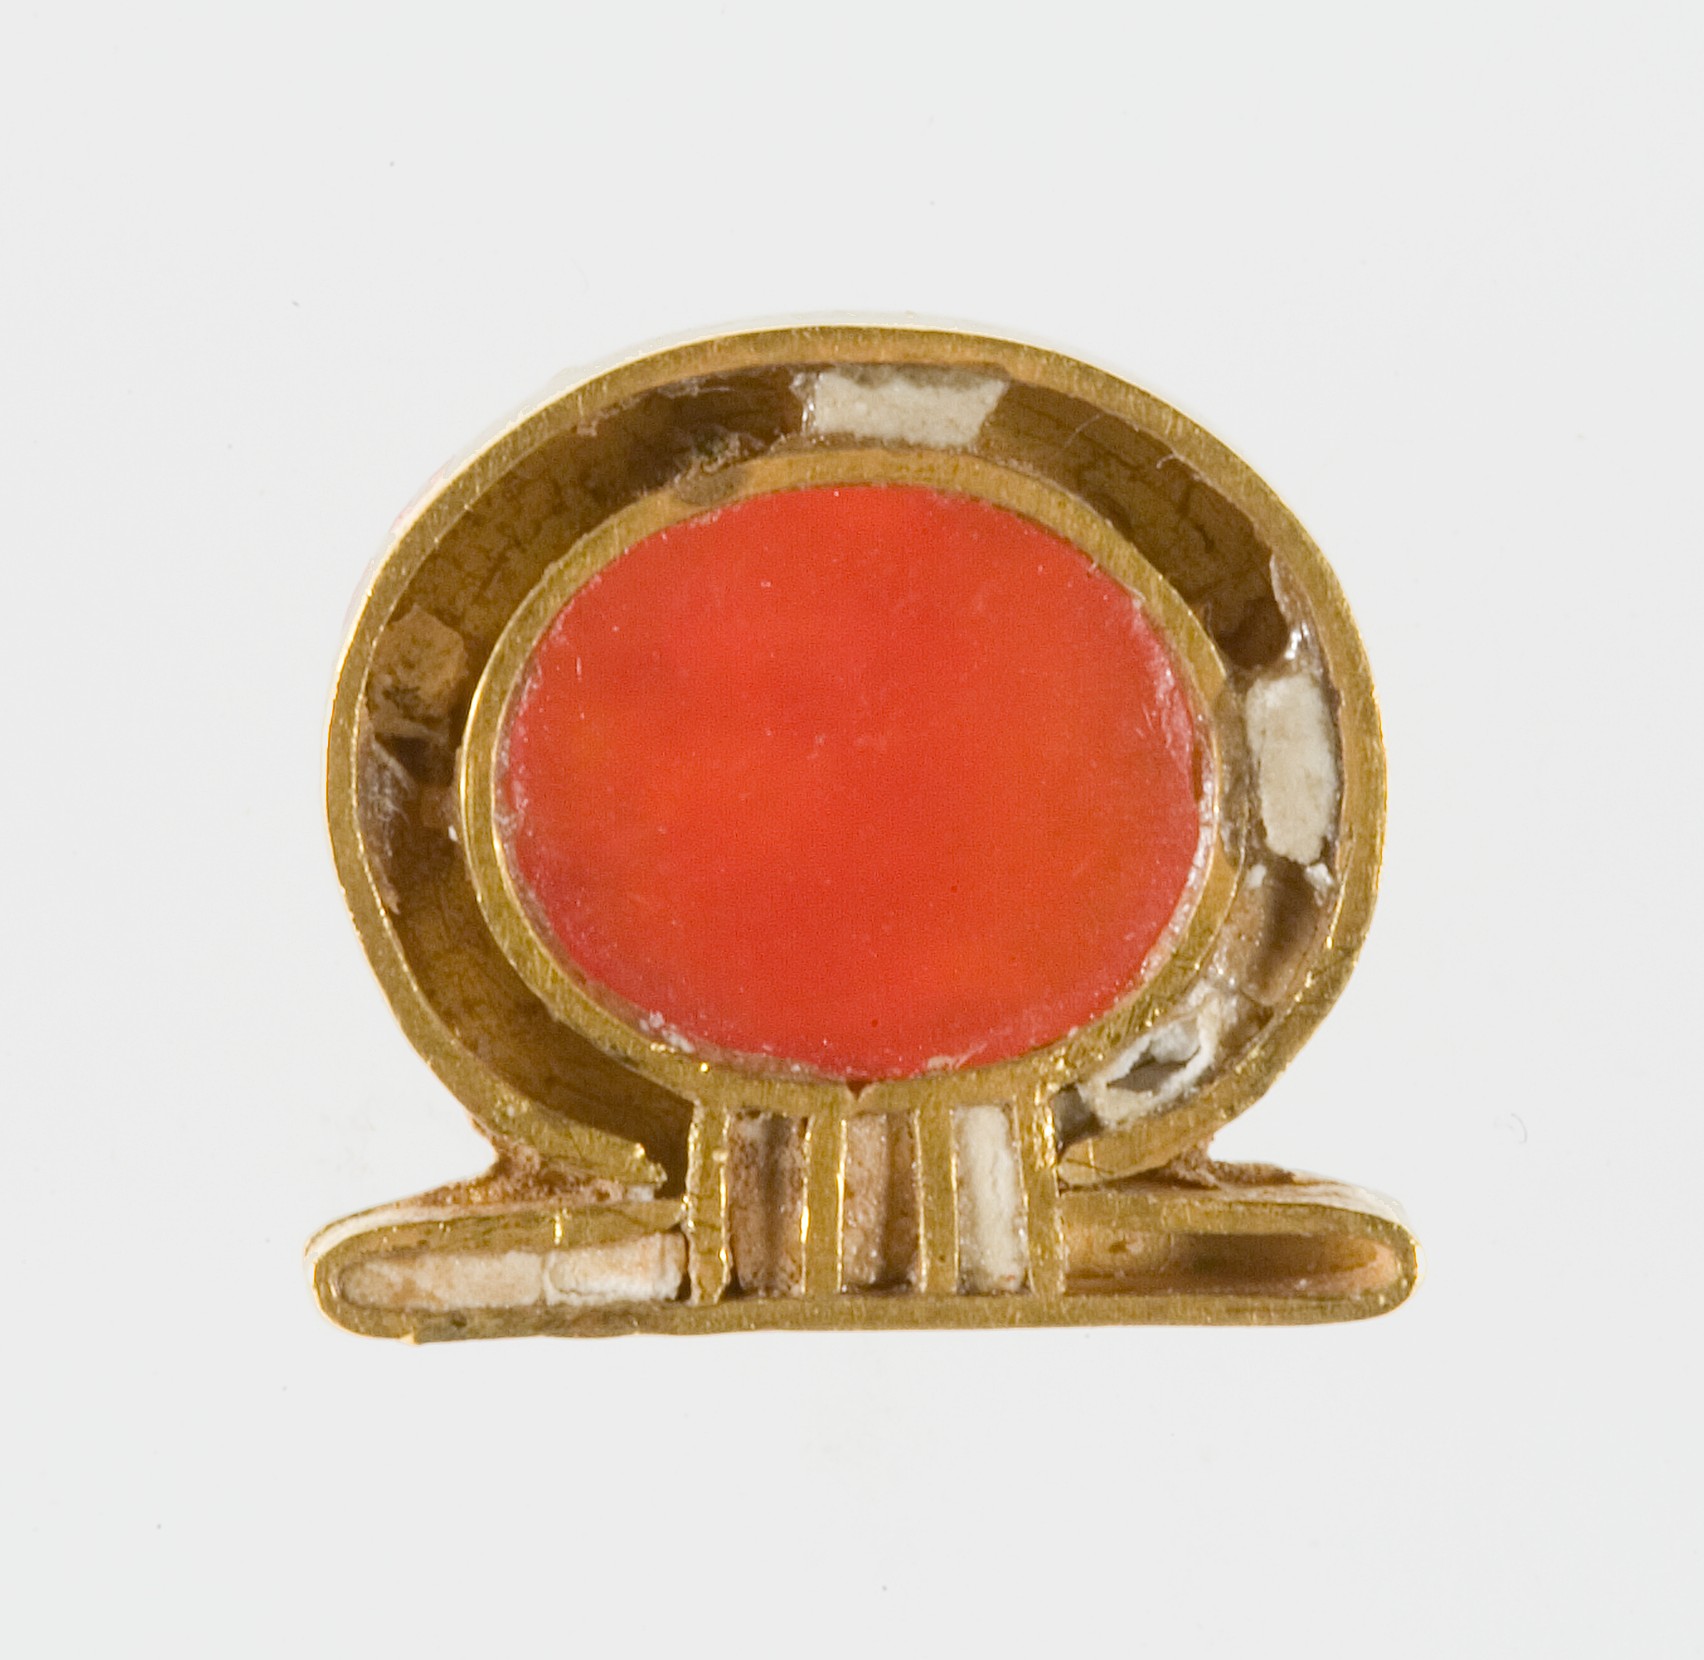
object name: clasp, sithathoryunet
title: Motto Clasp of Sithathoryunet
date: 1887-1813 BCE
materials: gemstone, gold, paste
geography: egypt